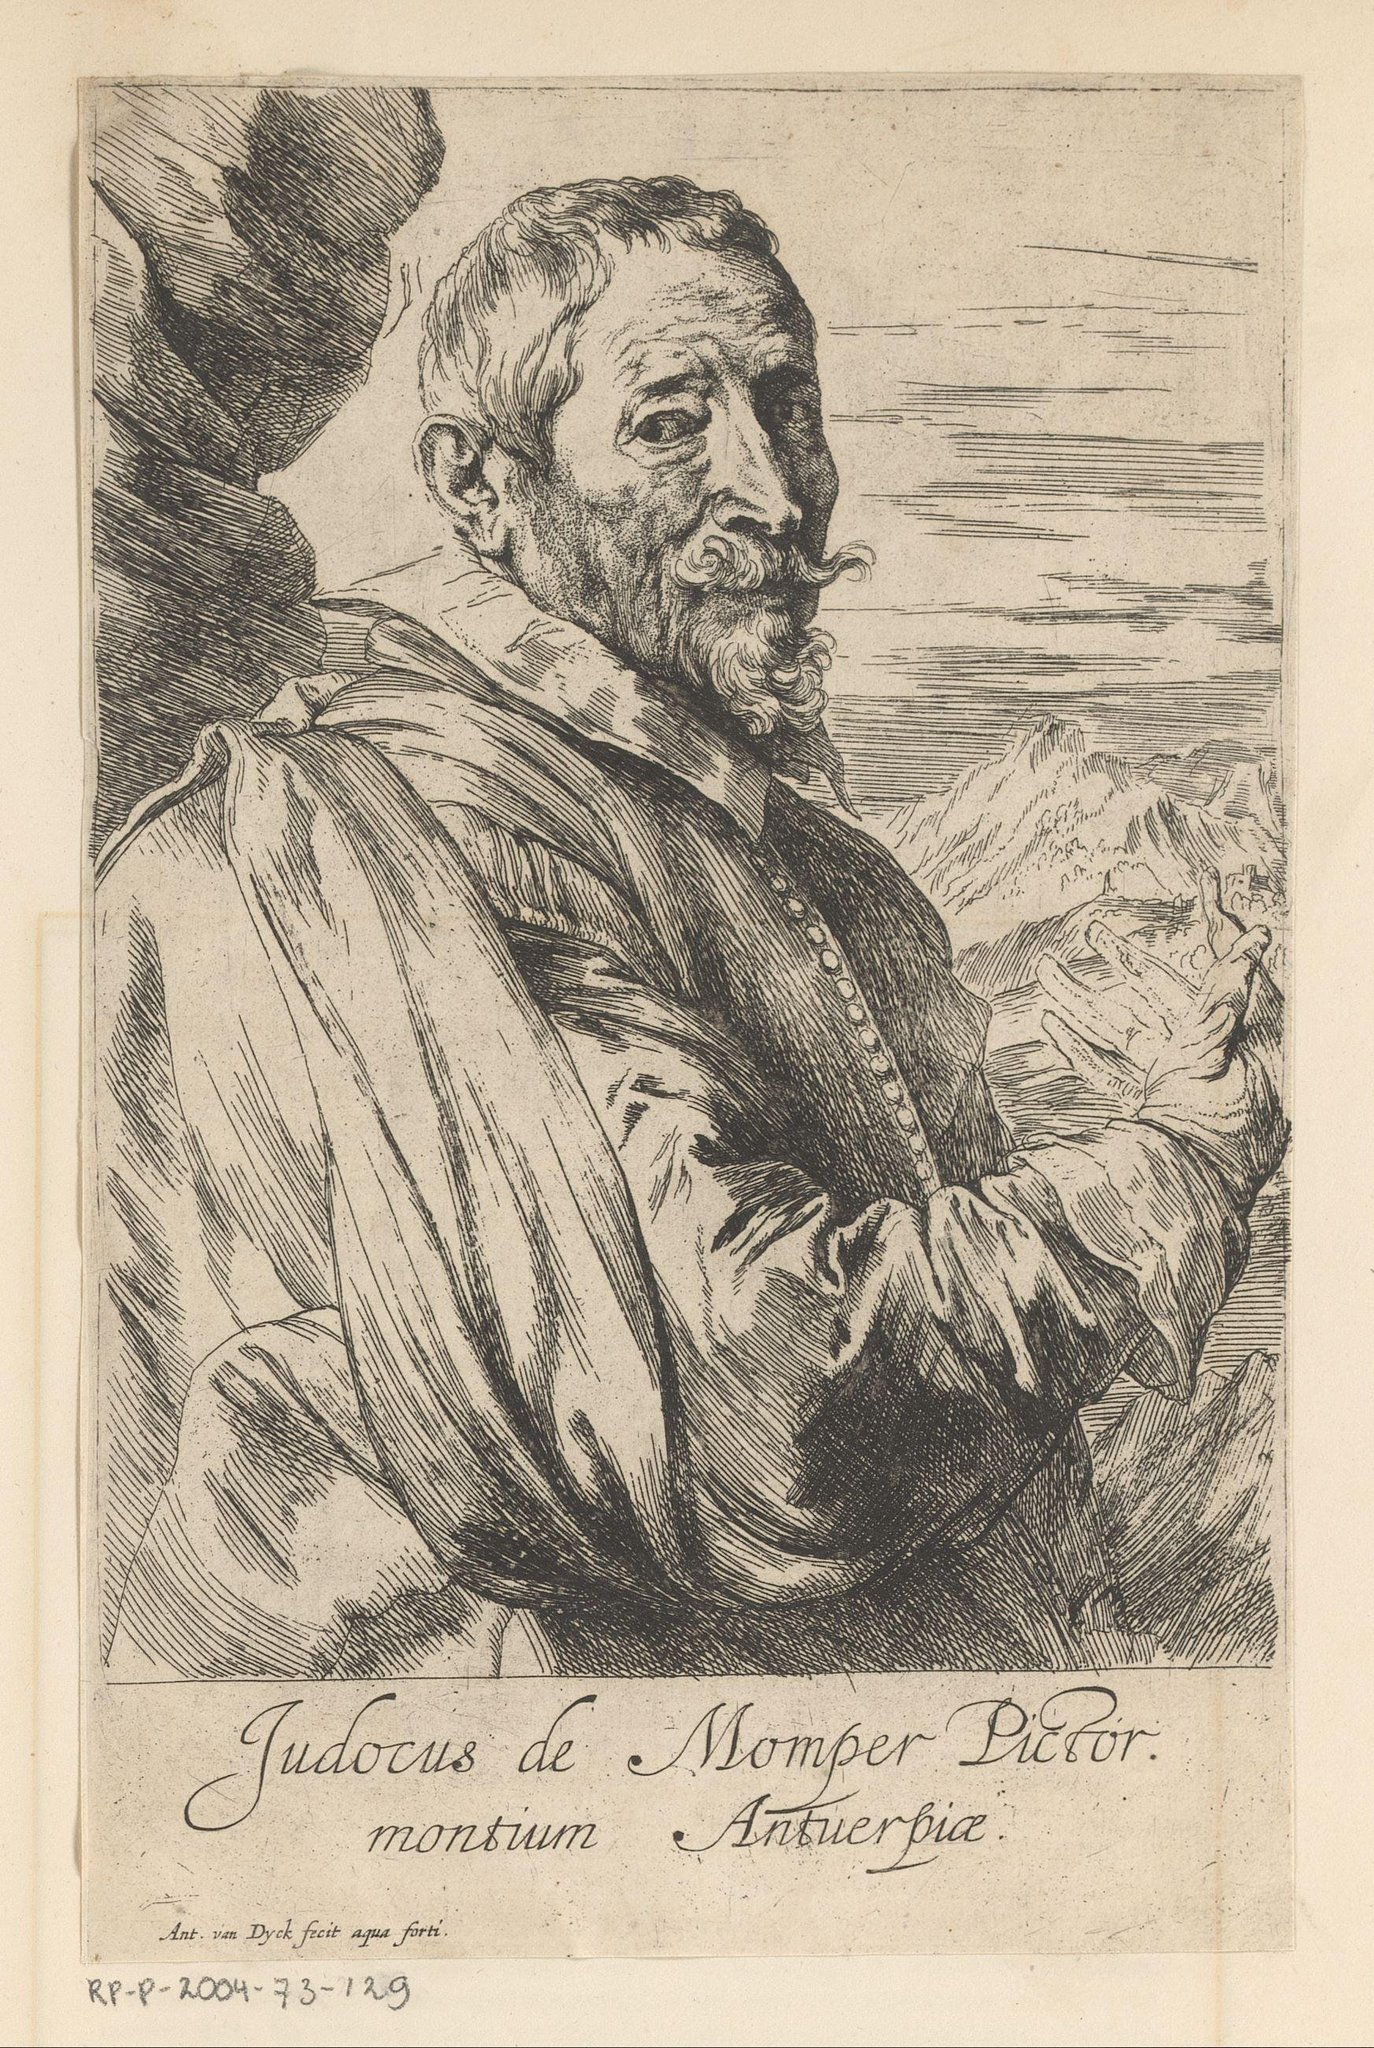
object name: album leaf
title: Iconographie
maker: anthony van dyck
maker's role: draughtsman, painter, print maker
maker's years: 1599-1641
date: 1630-1646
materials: paper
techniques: etching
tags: antwerp, painter, draughtsman, joos de momper (ii), historical persons, portrait, self-portrait of painter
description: Prent is ontworpen voor de serie getiteld 'Iconographie' samengesteld door Anthony van Dyck en uitgegeven in 1645-1646. Latere staat van prent gebruikt in: Iconographie ou Vies des Hommes Illustres du XVII. Siecle (...). 2 dln. Amsterdam: Johann Caspar Arkstee, Leipzig: Henricus Merkus, 1759, dl. 2, p. 32. De samensteller heeft deze prent in het album geplakt als illustratie bij: Pilkington, Matthew en Johann Heinrich Füssli. A dictionary of painters, from the revival of the art to the present period. 4 dln. Londen: John Crowder, 1805, dl. 2, p. 301.